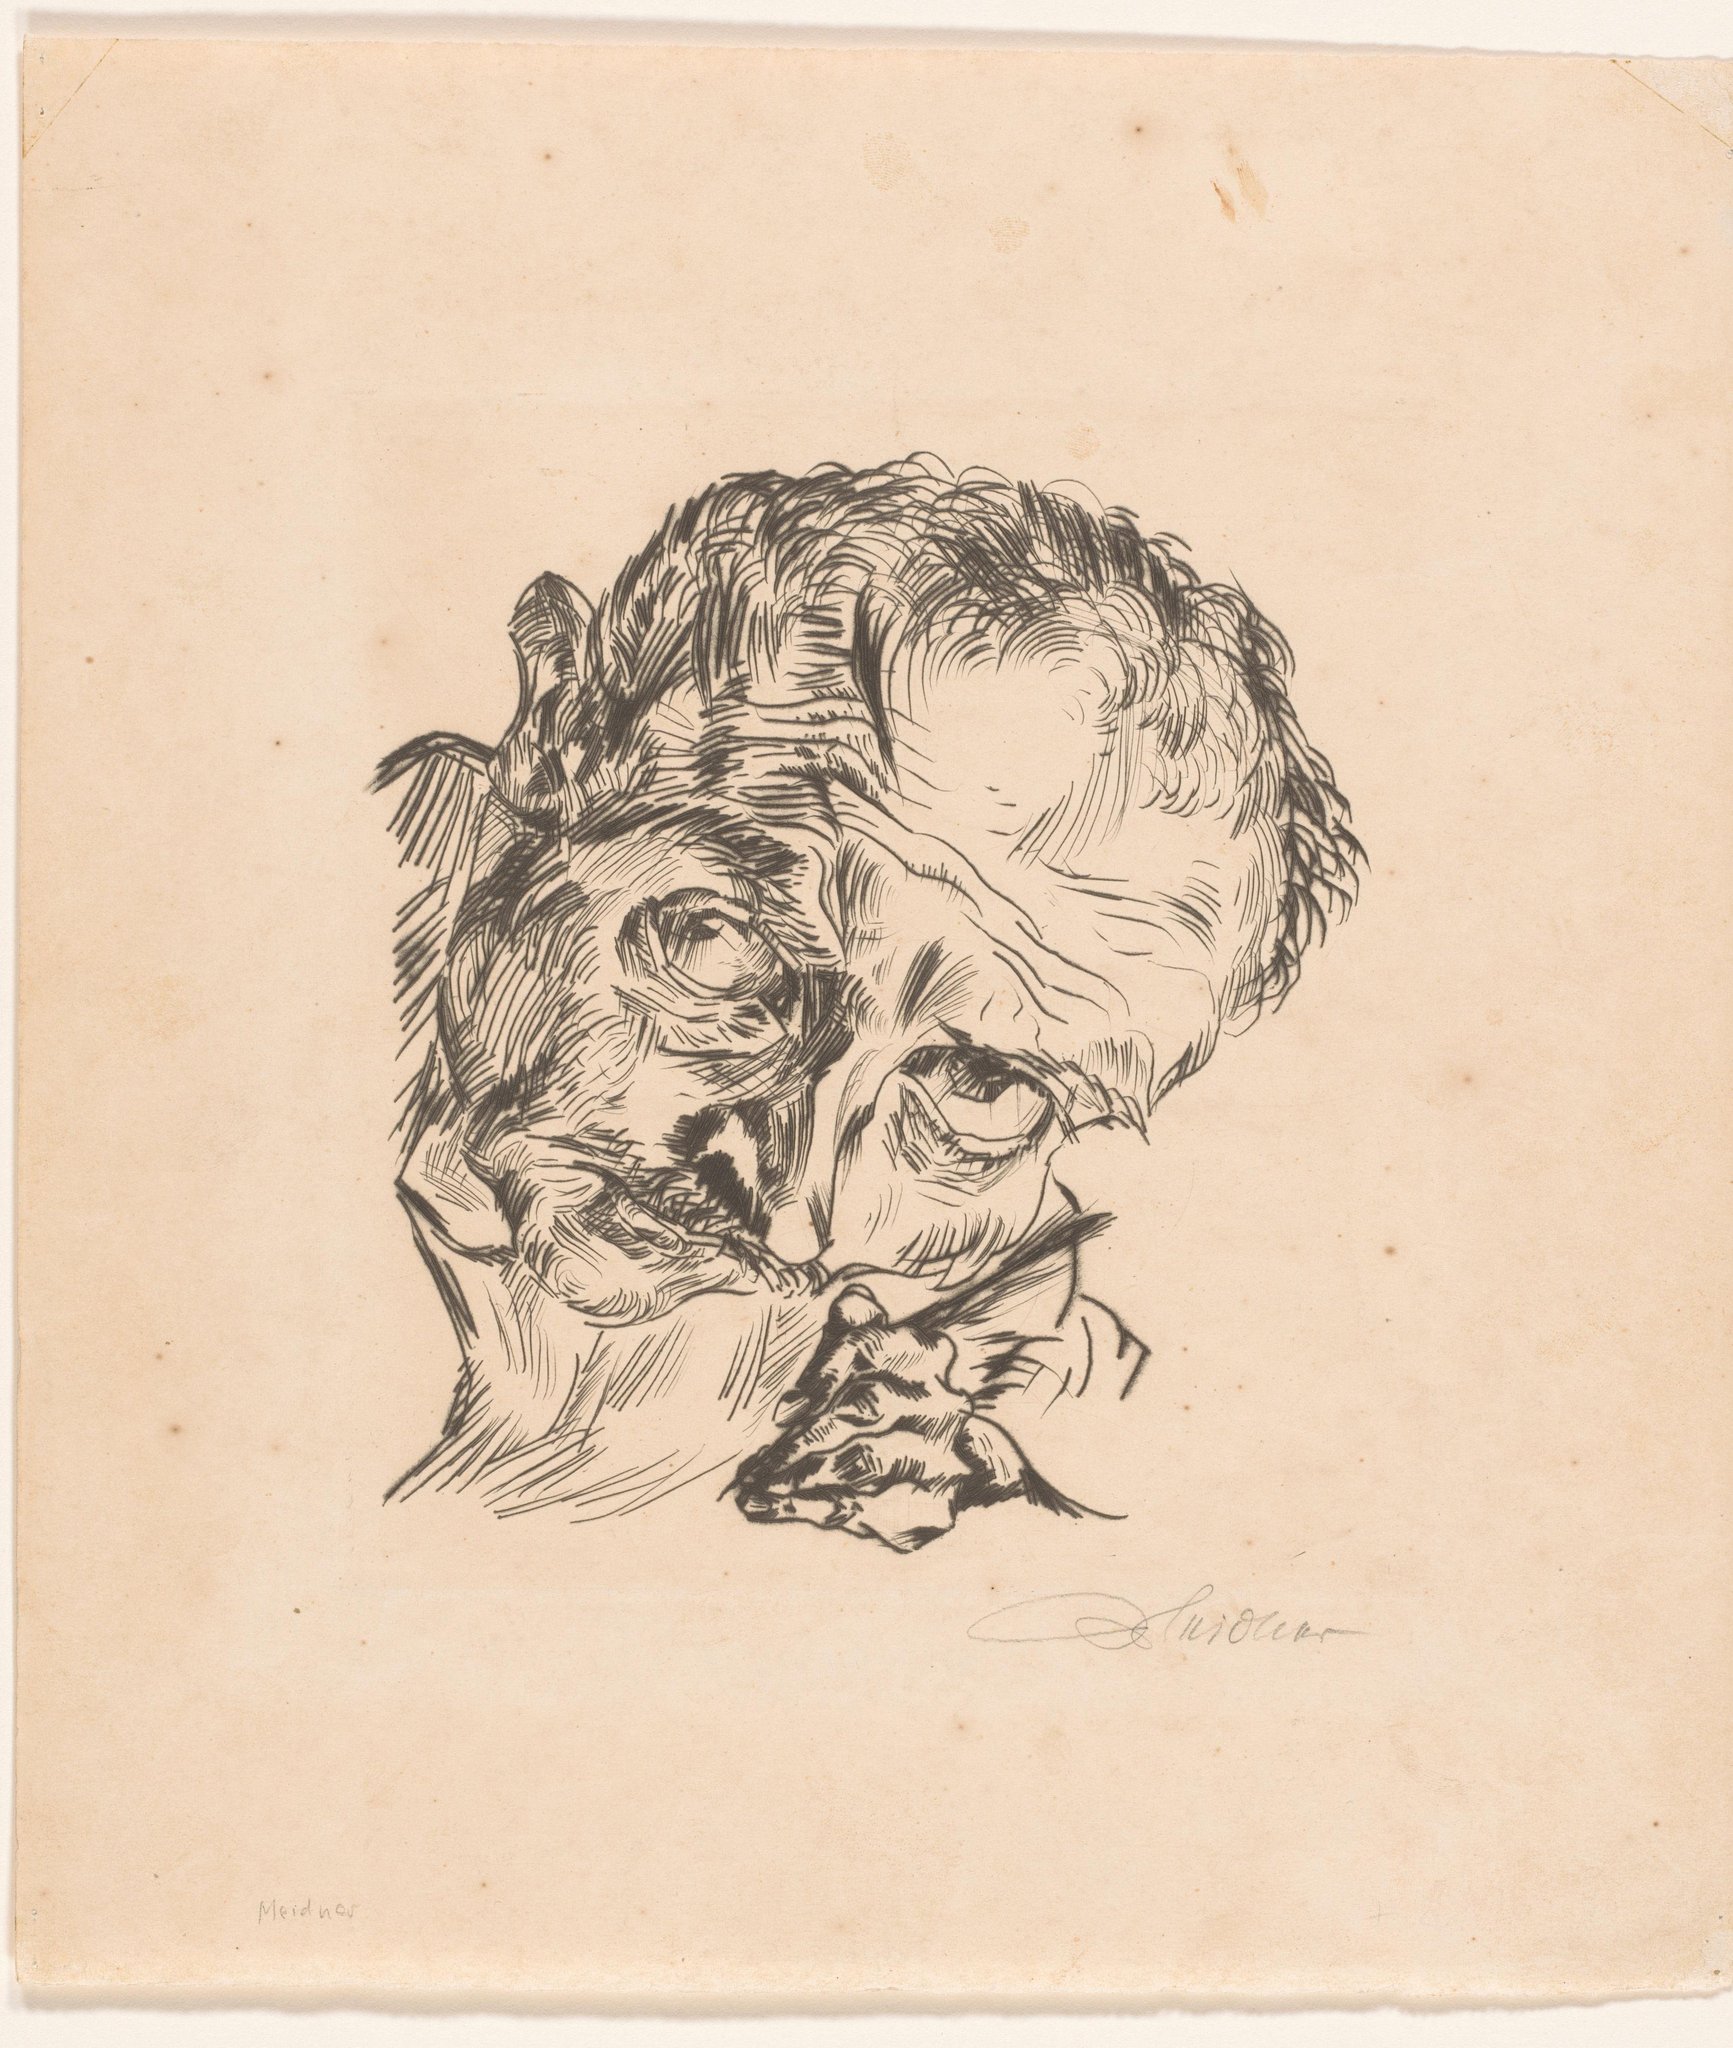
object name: print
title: Zelfportret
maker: ludwig meidner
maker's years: 1884-1966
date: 1919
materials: paper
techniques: drypoint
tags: ludwig meidner, portrait, self-portrait of graphic artist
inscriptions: collector's mark: Lugt 2760, collector's mark: Lugt 2228